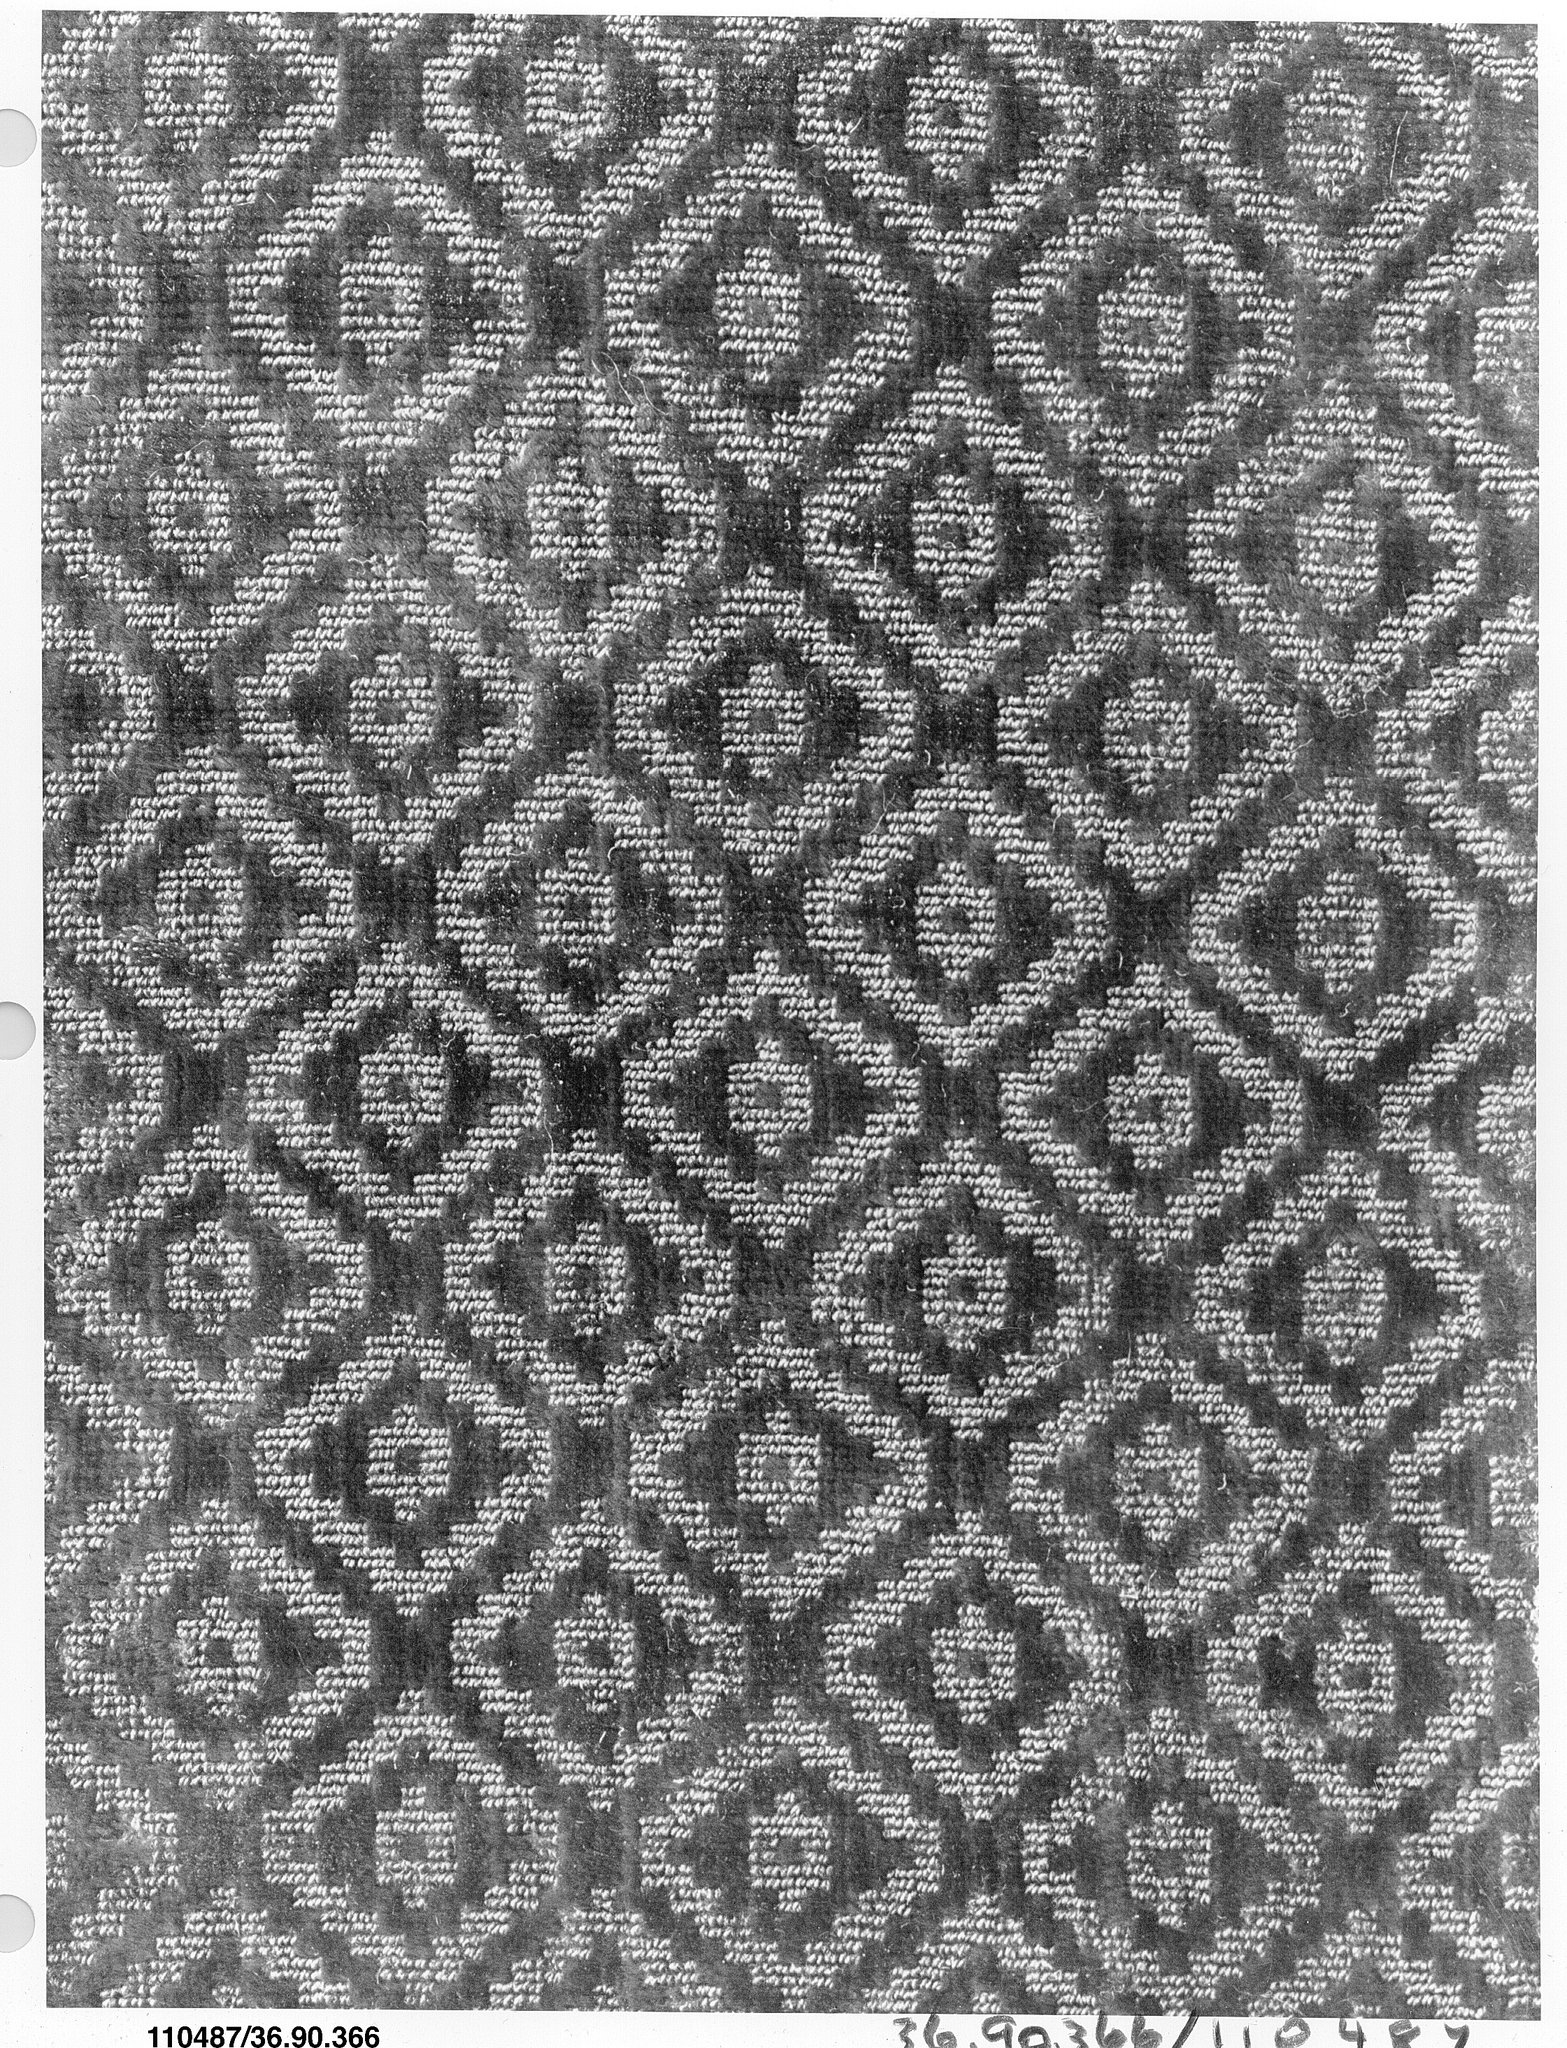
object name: piece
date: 1501-1700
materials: silk